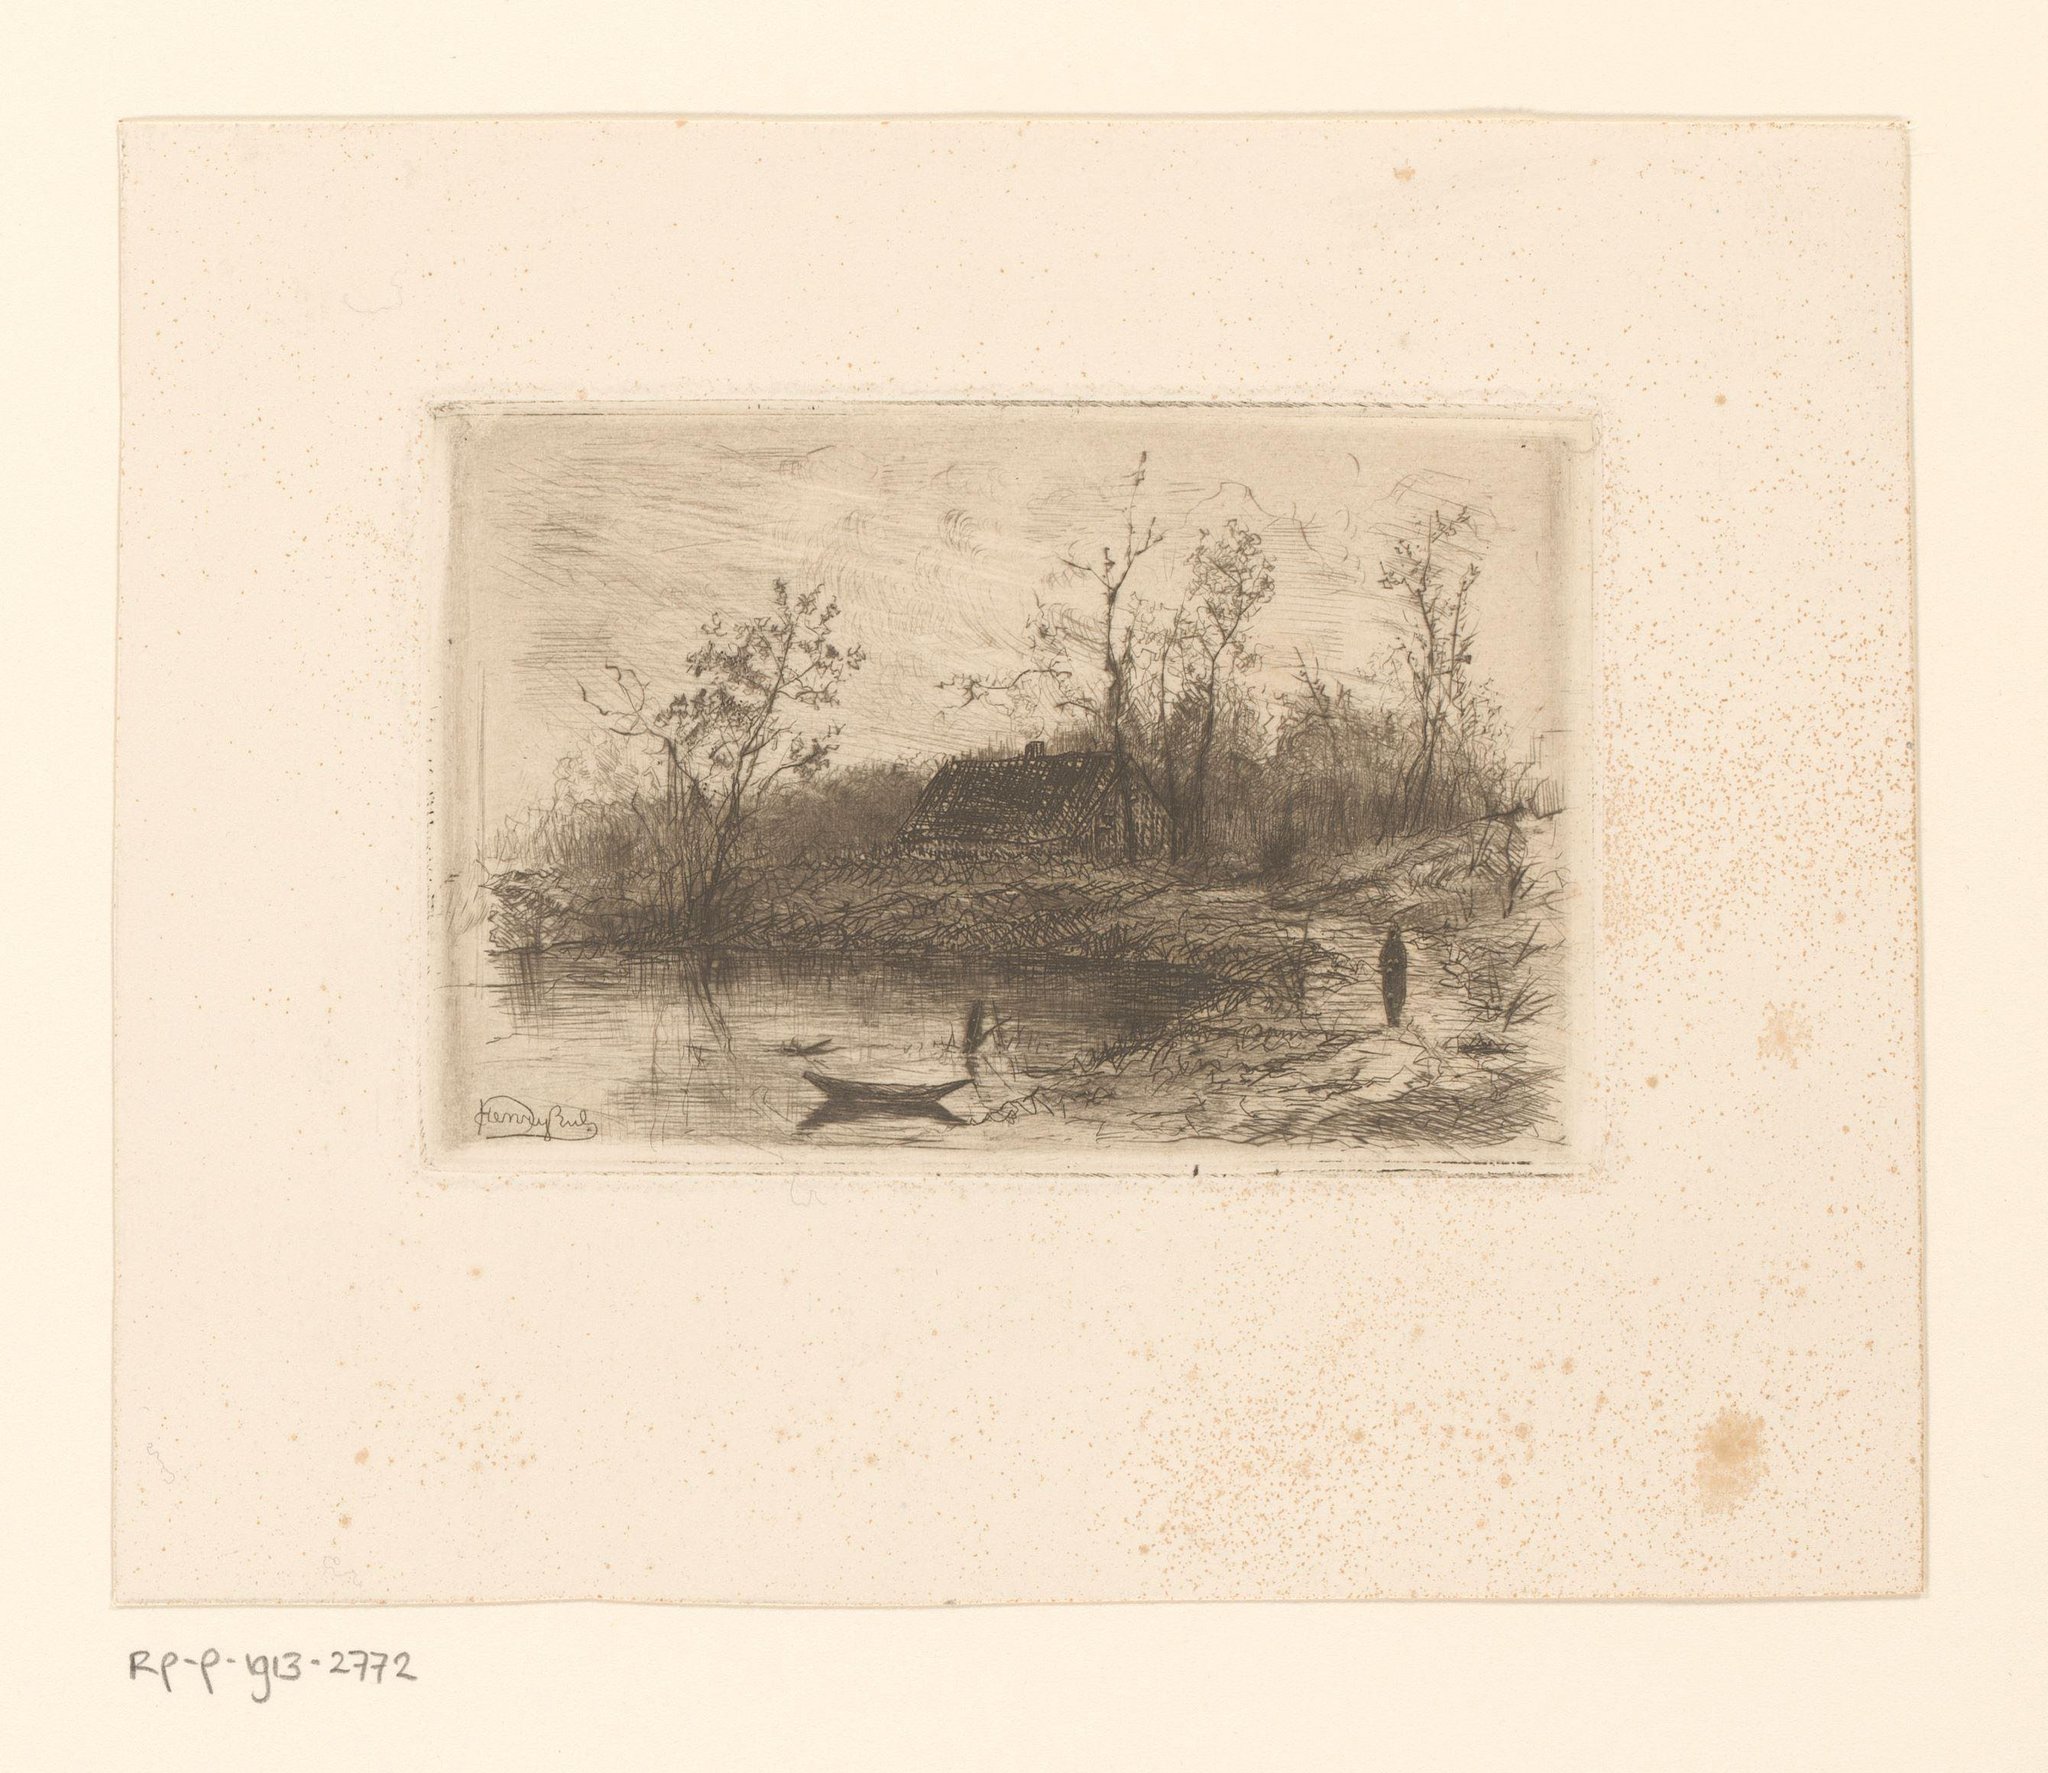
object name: print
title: Landschap met huis aan een water met boot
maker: henri rul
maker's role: print maker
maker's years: 1862-1942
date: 1872-1913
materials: paper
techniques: drypoint, etching, intaglio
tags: water course, farm or solitary house in landscape (+ city(-scape) with figures, staffage)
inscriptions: collector's mark: Lugt 2228